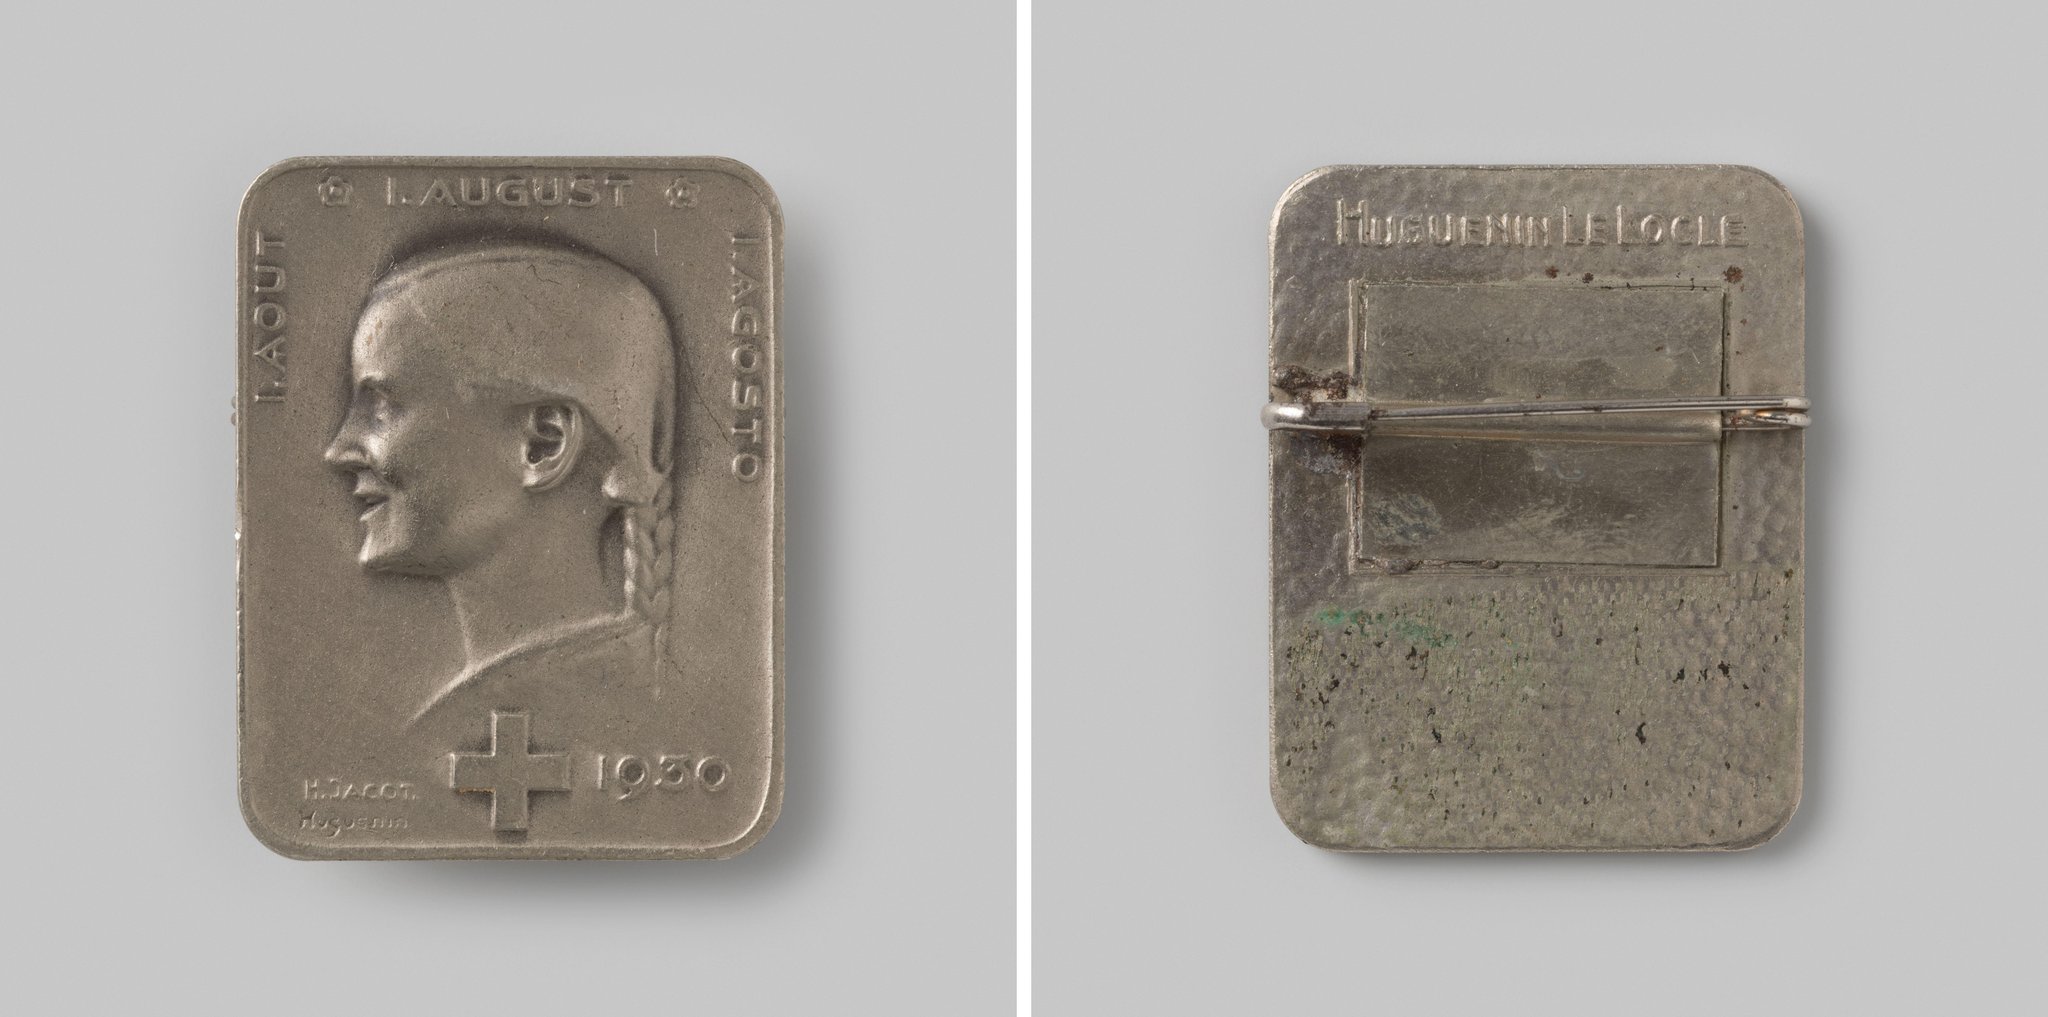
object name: history medal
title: 1 Augustus Zwitserse Nationale Feestdag 1930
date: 1930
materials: metal alloy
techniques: pressing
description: Rechthoekige witmetalen broche waarop een meisjesportret boven een Zwitsers kruis, met omschrift.